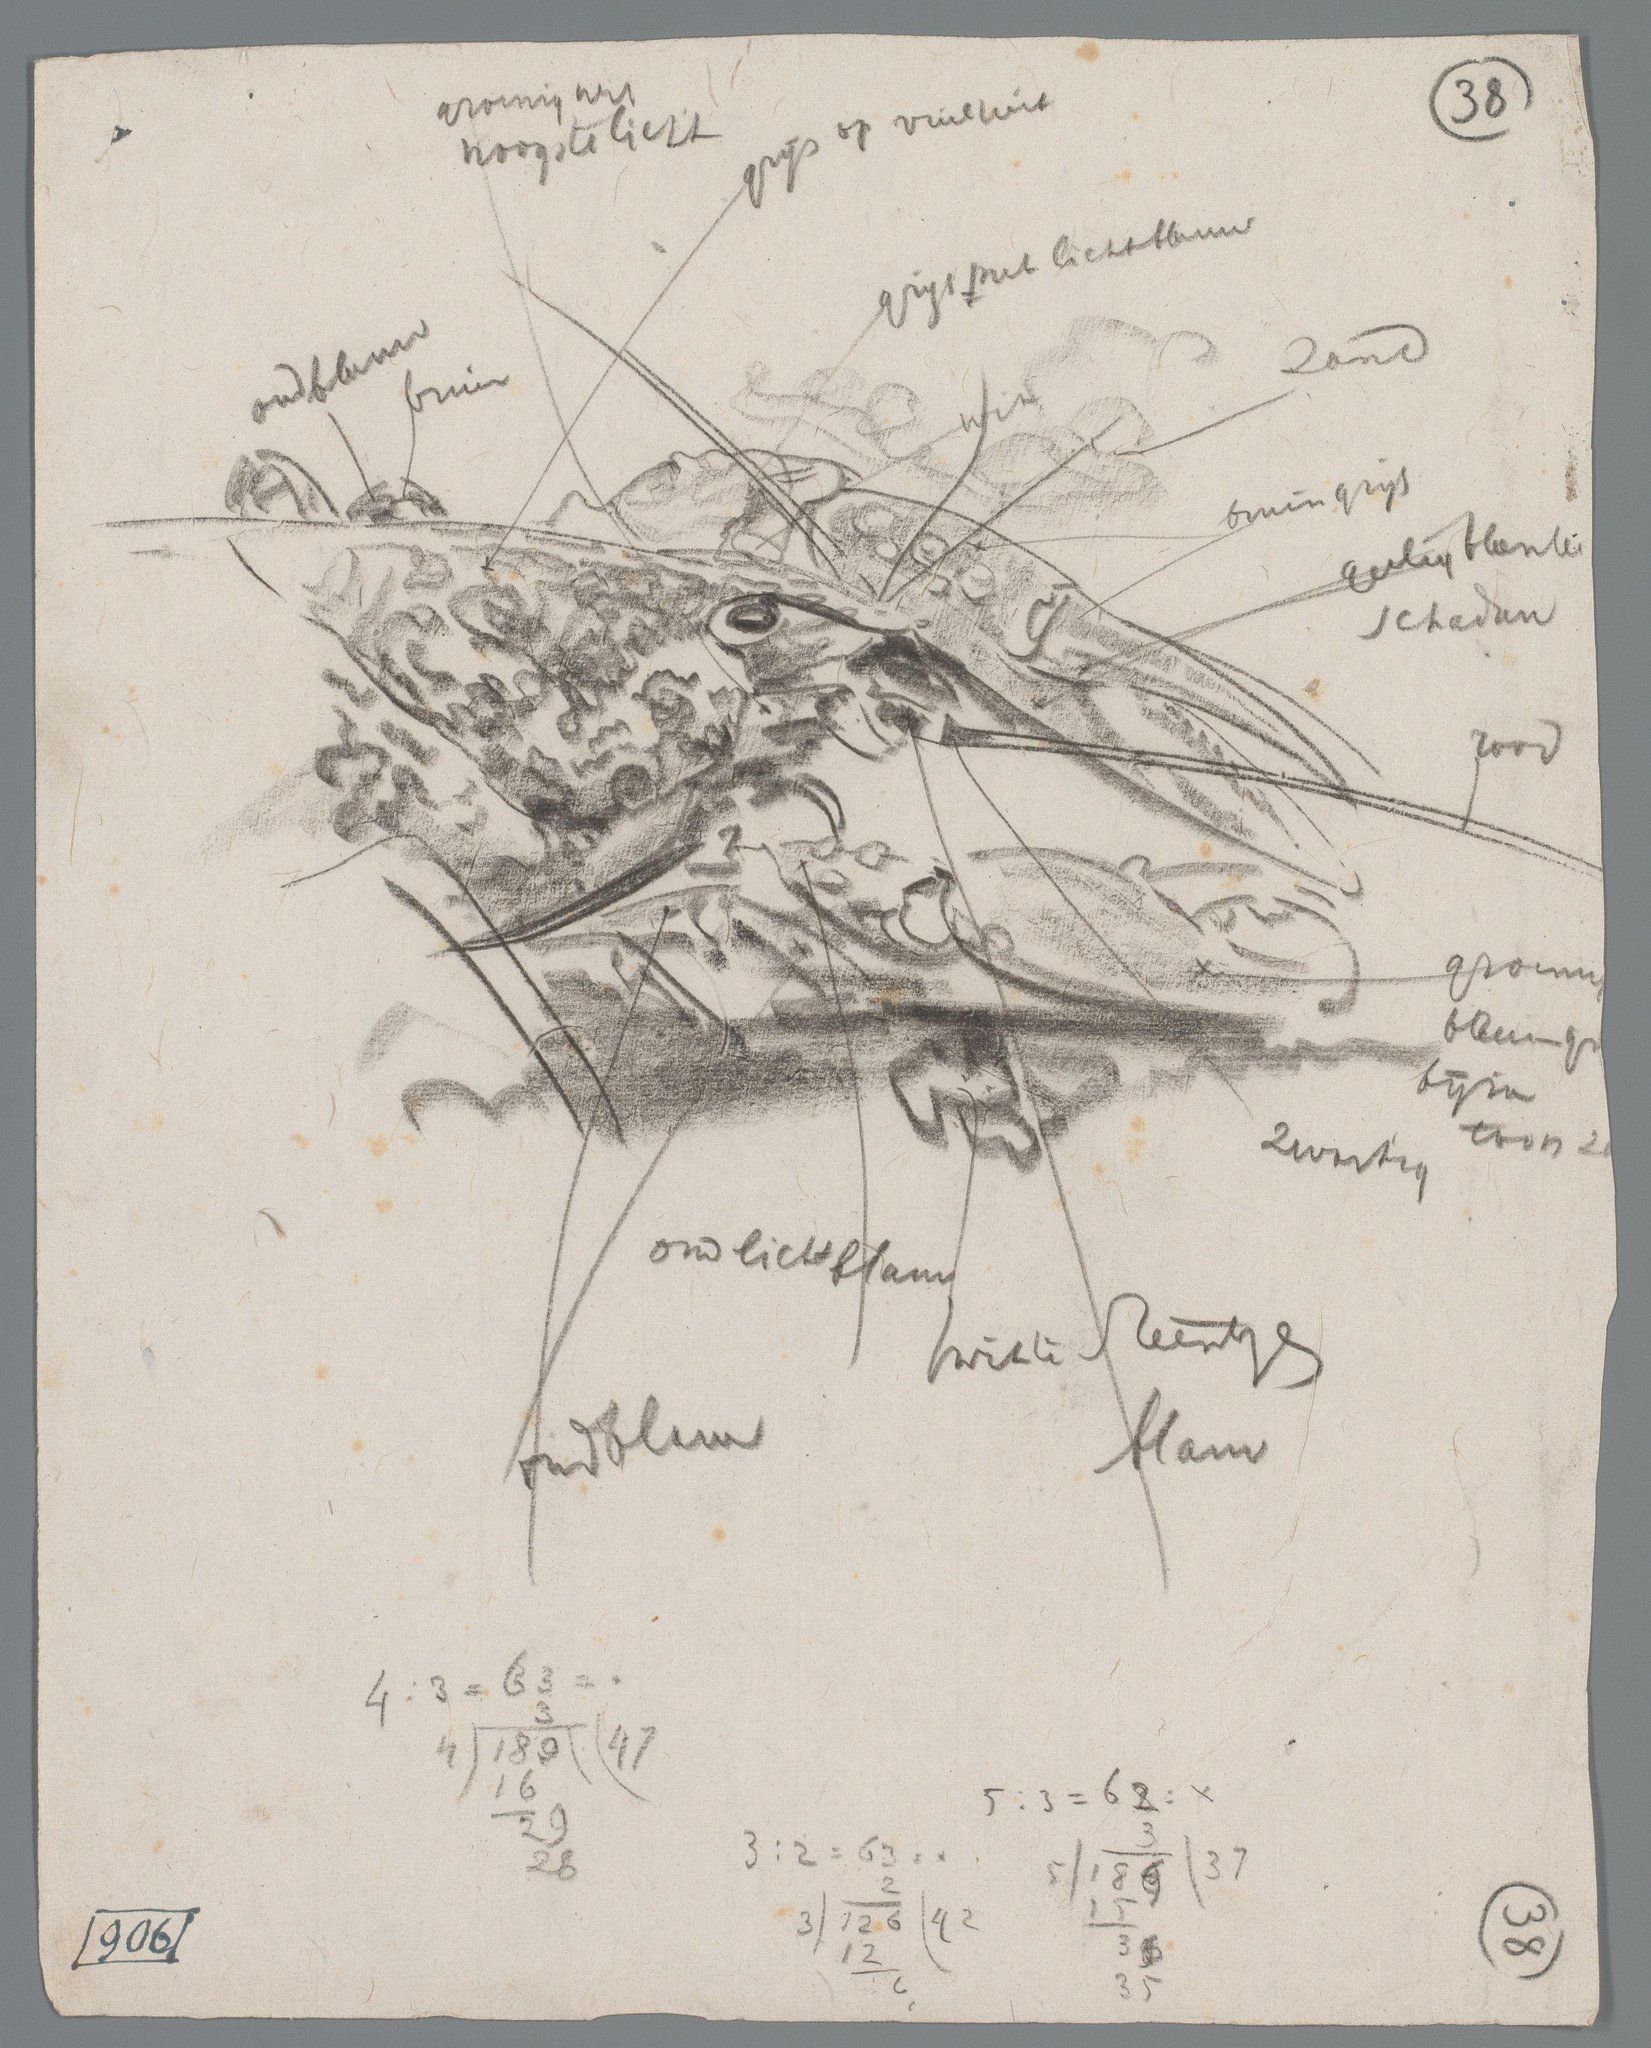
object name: drawing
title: Studies van de kop en scharen van een kreeft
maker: gerrit willem dijsselhof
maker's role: designer, draughtsman, print maker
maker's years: 1866-1924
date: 1876-1924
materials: chalk, paper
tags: crustaceans: lobster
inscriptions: number: ‘38’, annotation, number: ‘906’